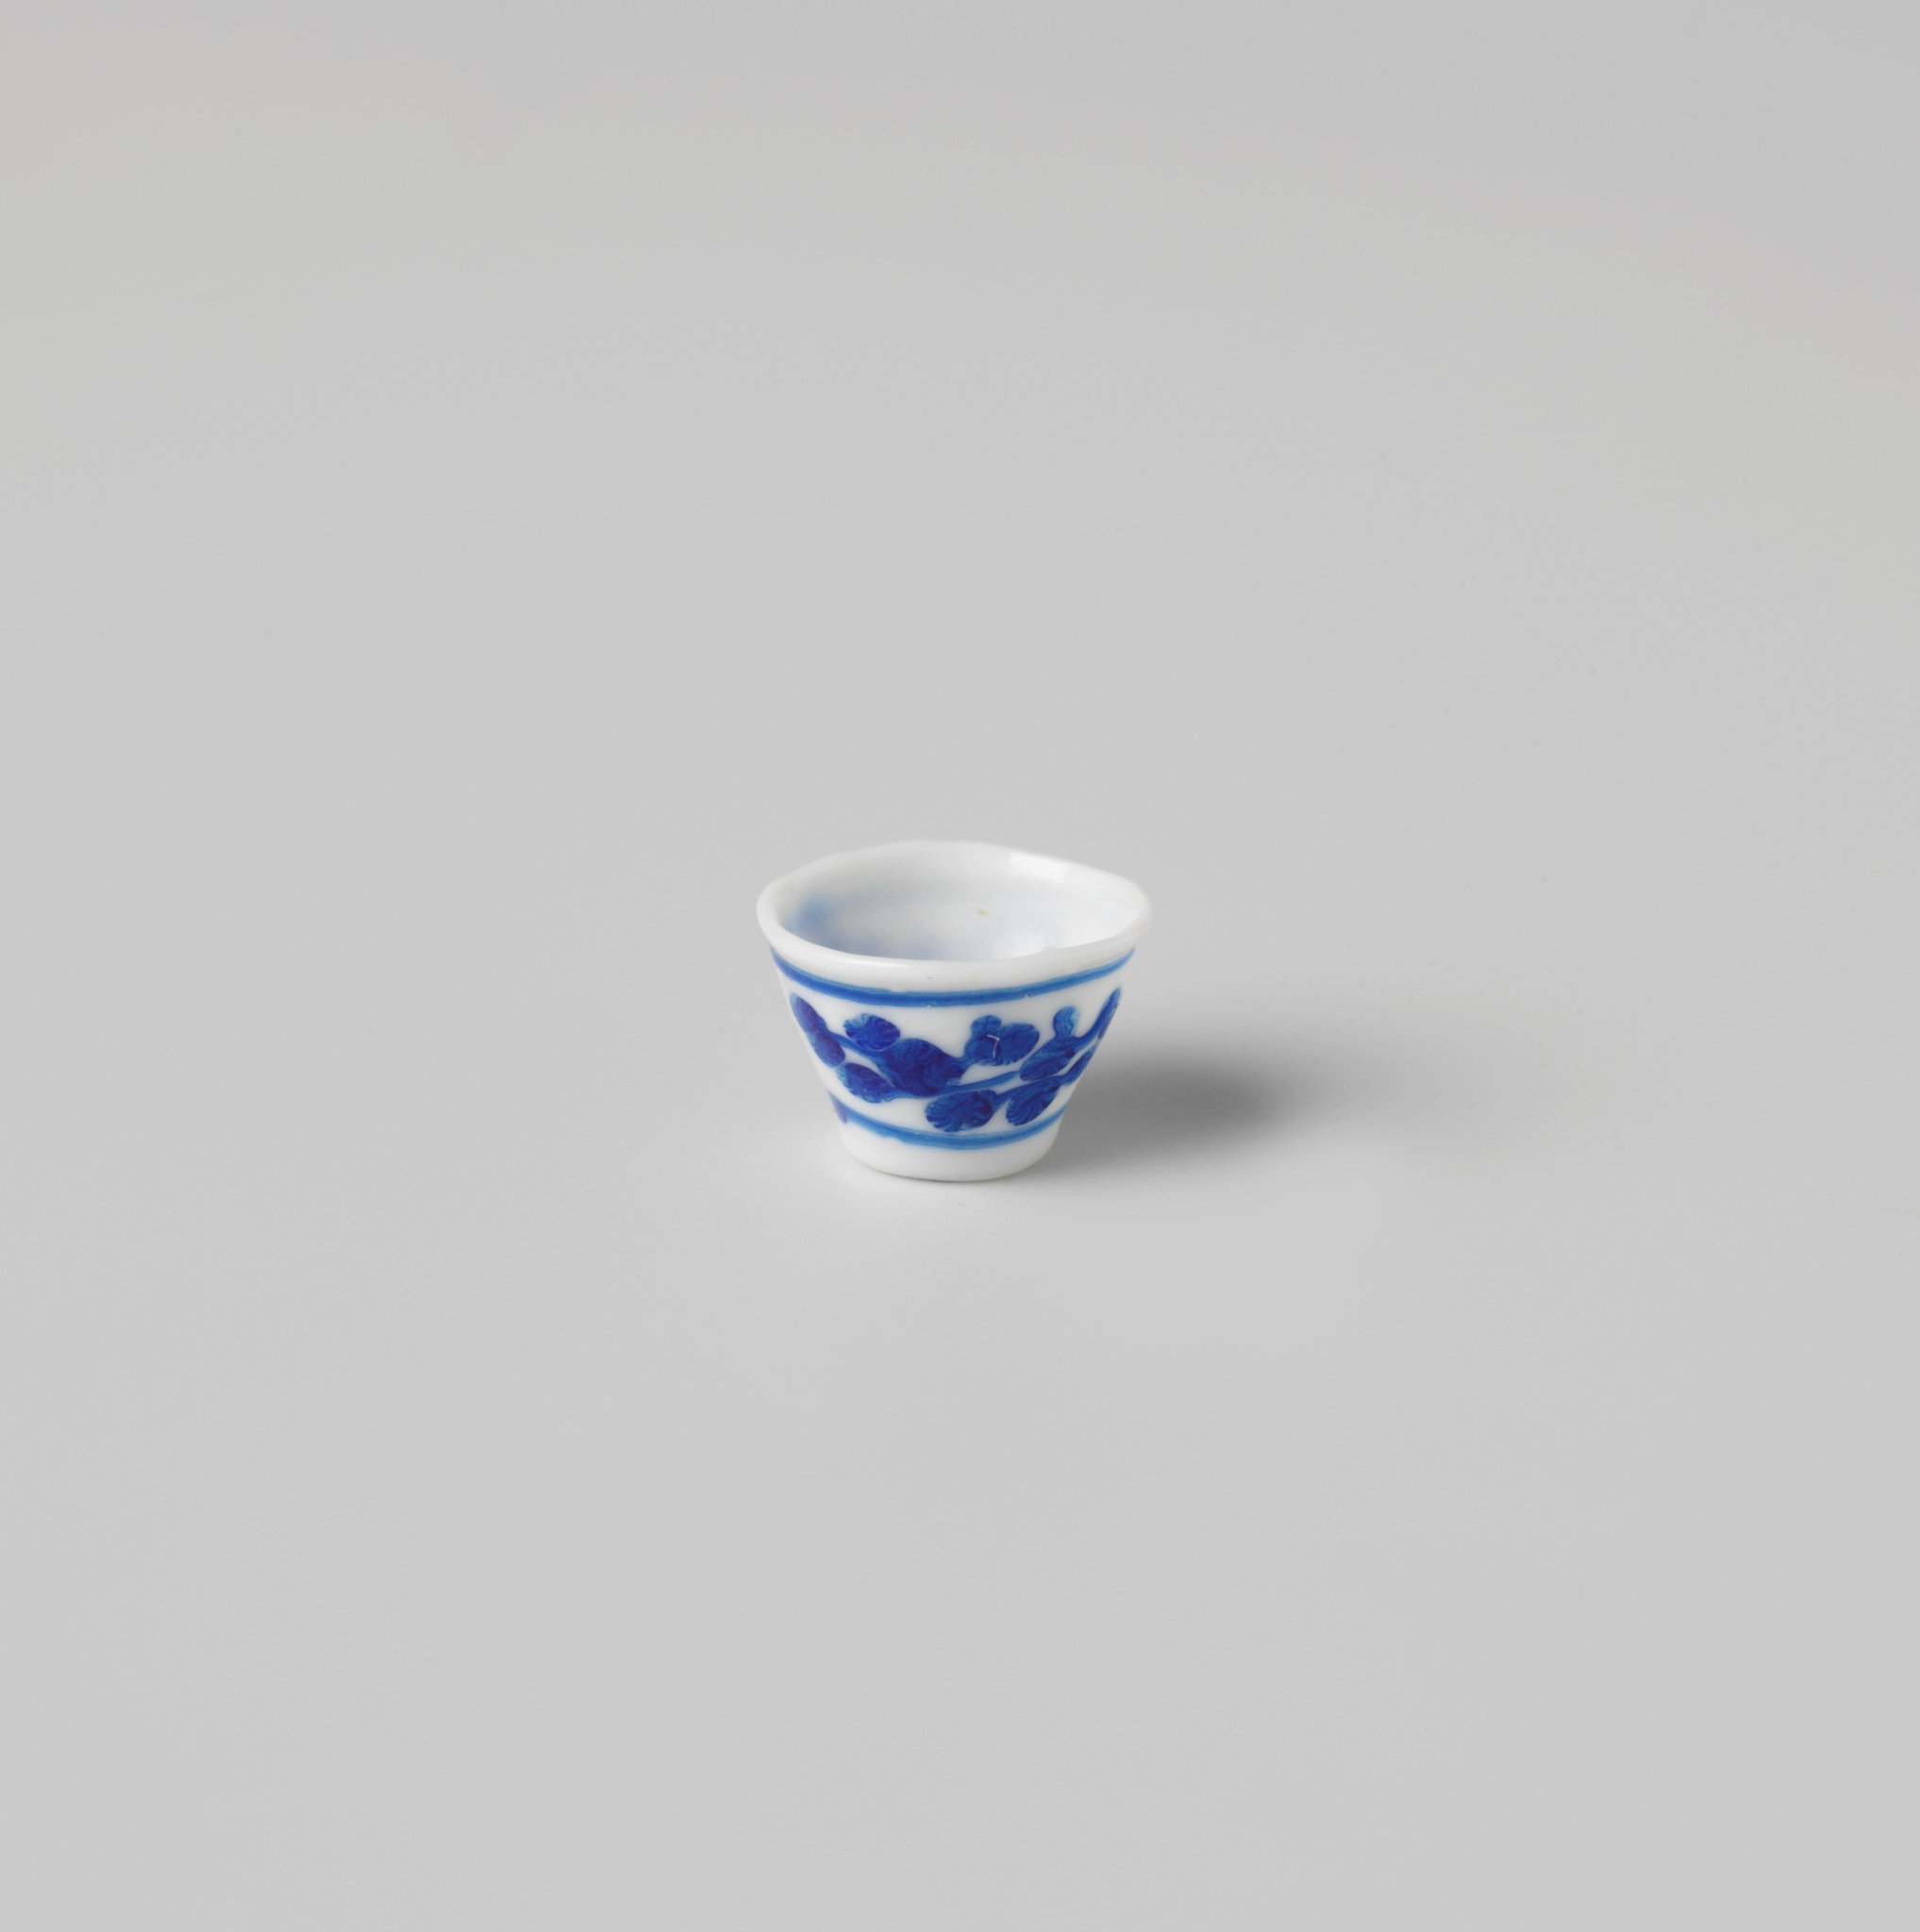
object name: bowl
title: Kom, wit, beschilderd in blauw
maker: Anonymous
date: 1675-1699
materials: glass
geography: haarlem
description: Kom van melkglas met blauwe emailverf beschilderd. Imitatie chinees blauw porselein.